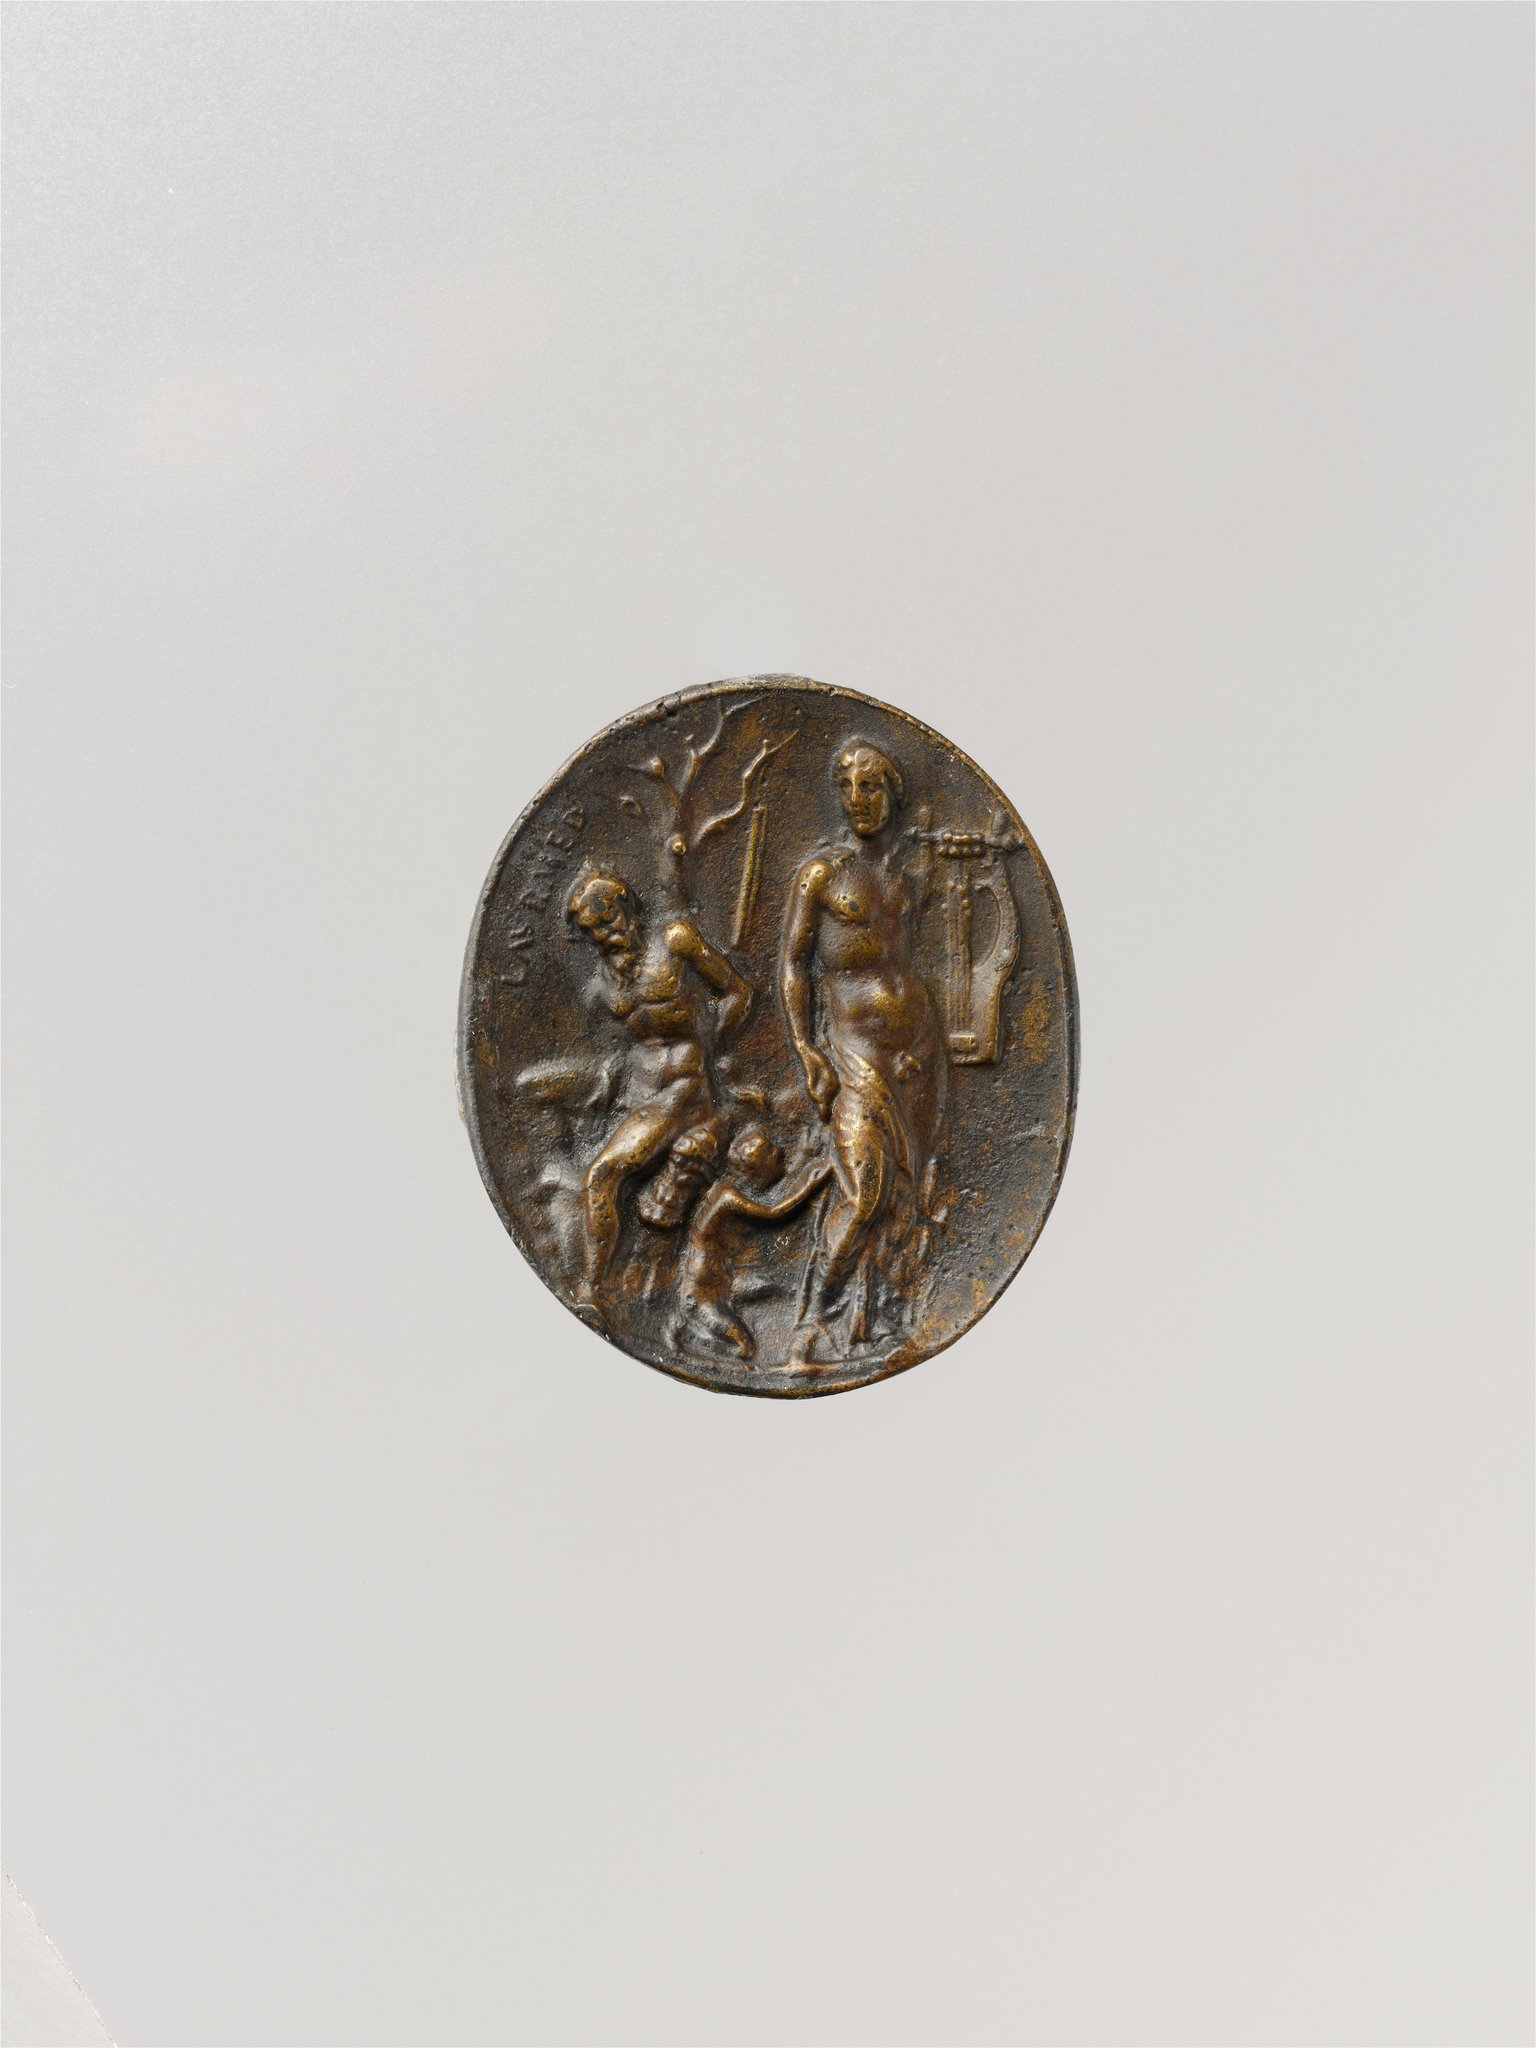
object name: plaquette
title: Apollo and Marsyas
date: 1401-1500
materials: brass, bronze, gilt bronze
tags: apollo